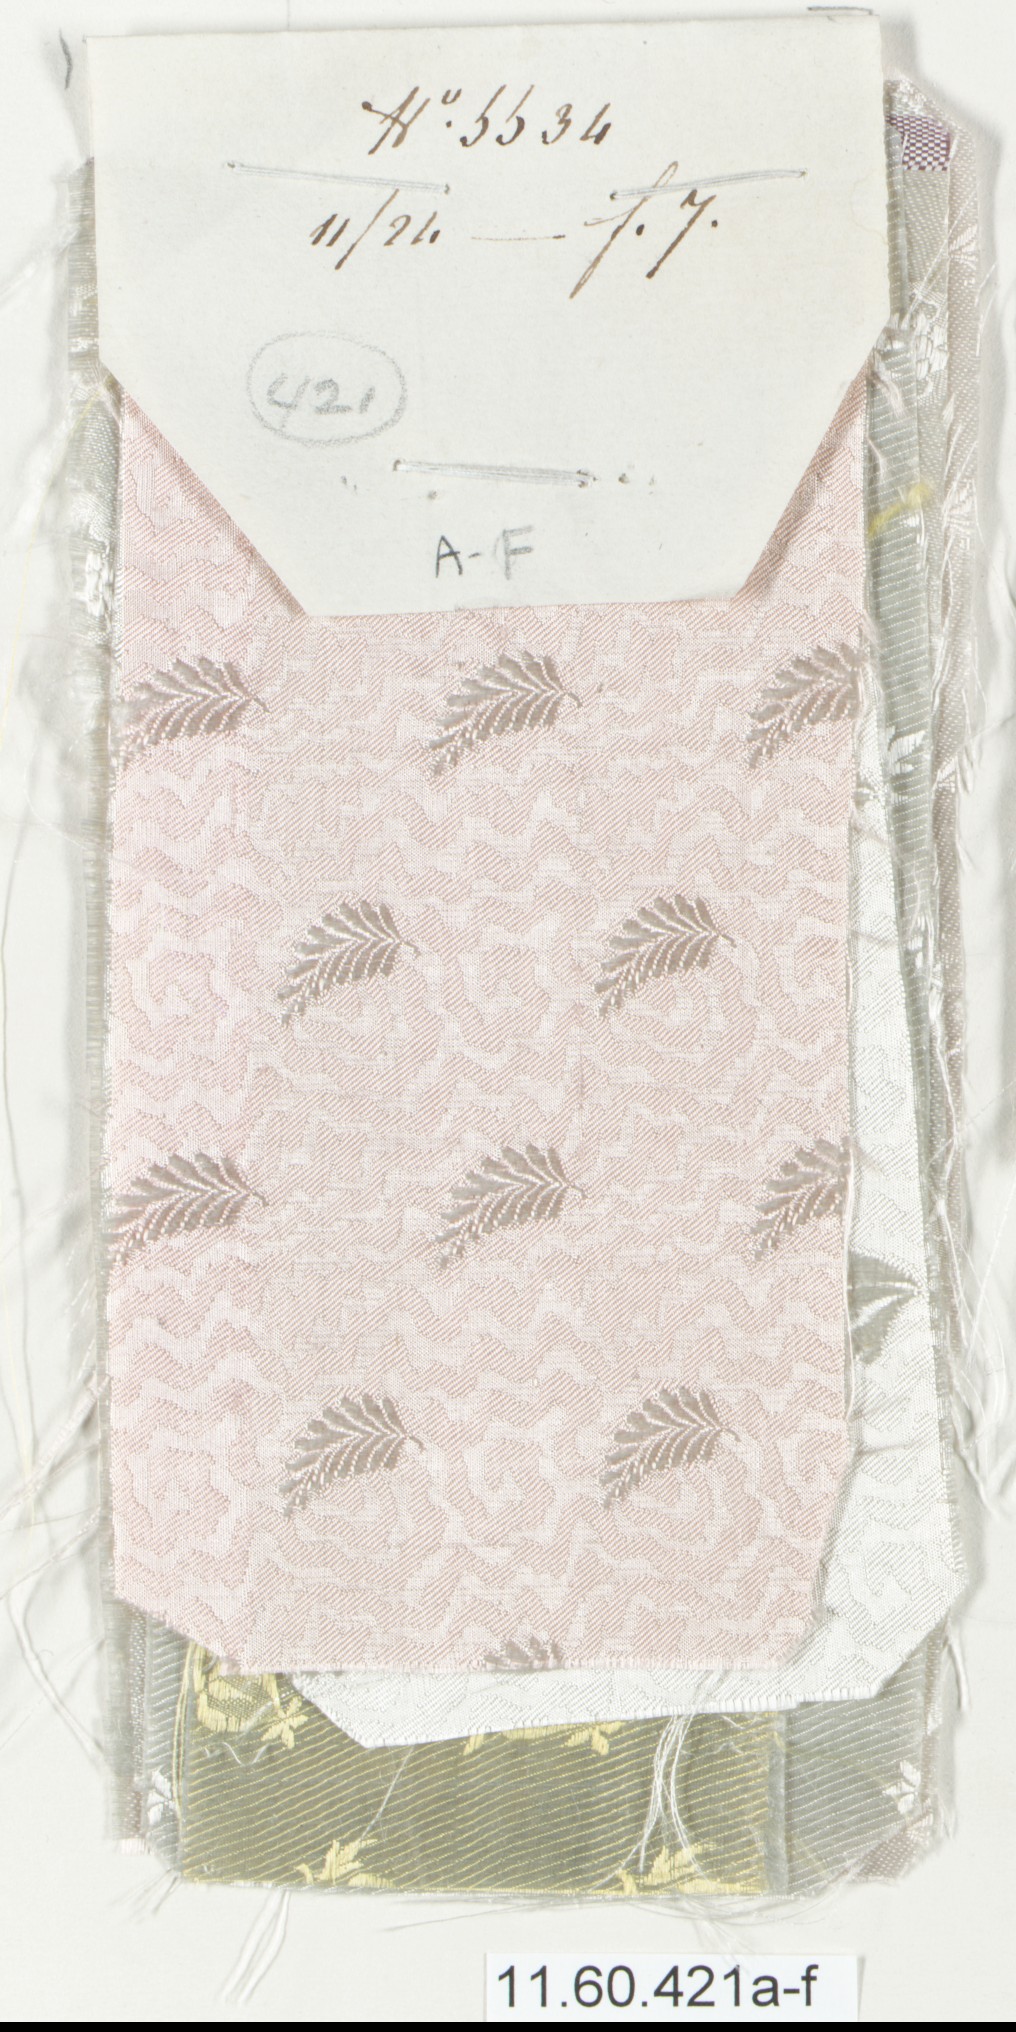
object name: fragment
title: Fragments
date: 1801-1900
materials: silk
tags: leaves